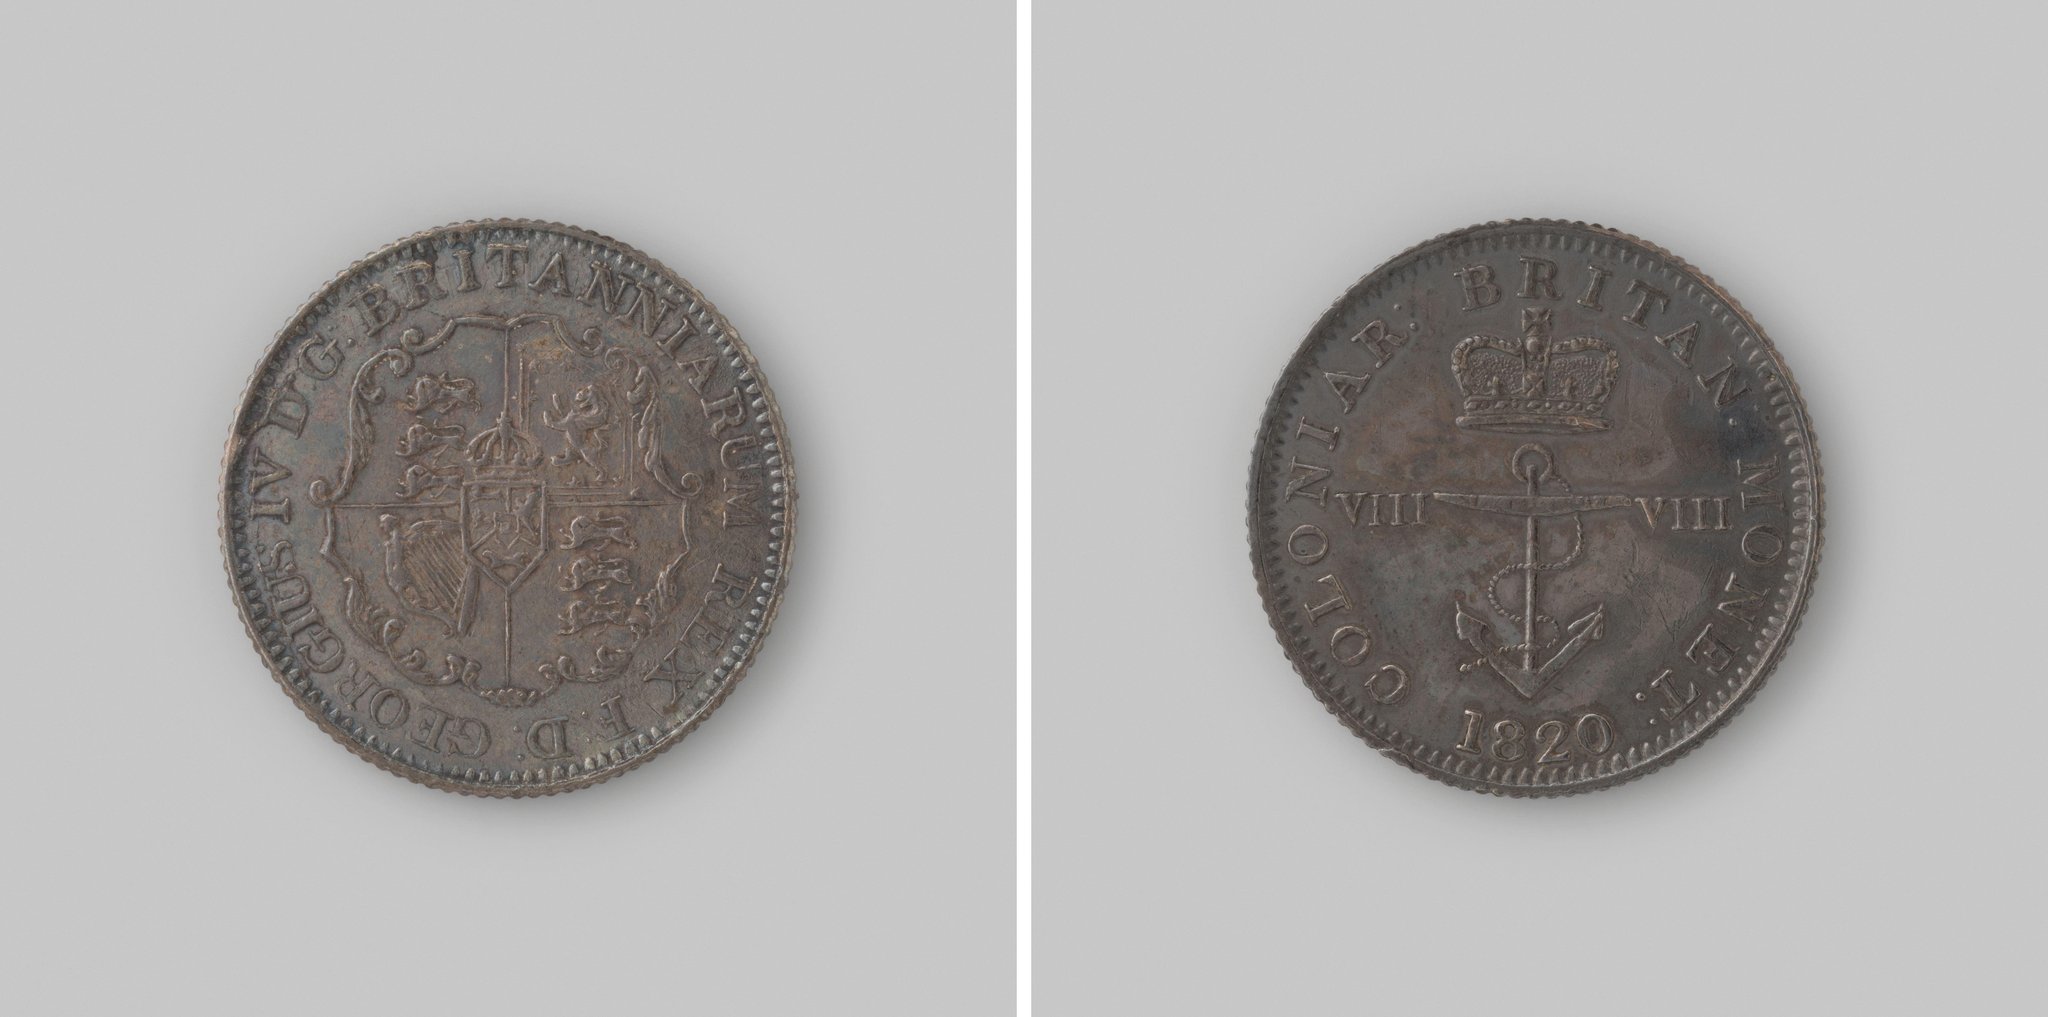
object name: coin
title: Mauritius, koning George IV, 1/4 dollar, 1820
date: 1820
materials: silver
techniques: striking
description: Zilveren munt. Voorzijde: versierd samengesteld wapenschild. Keerzijde: tussen waarde-aanduidingen IV [voor: 1/4 ] en IV anker met touw, waarboven kroon. Daaronder jaartal. Kartelrand.